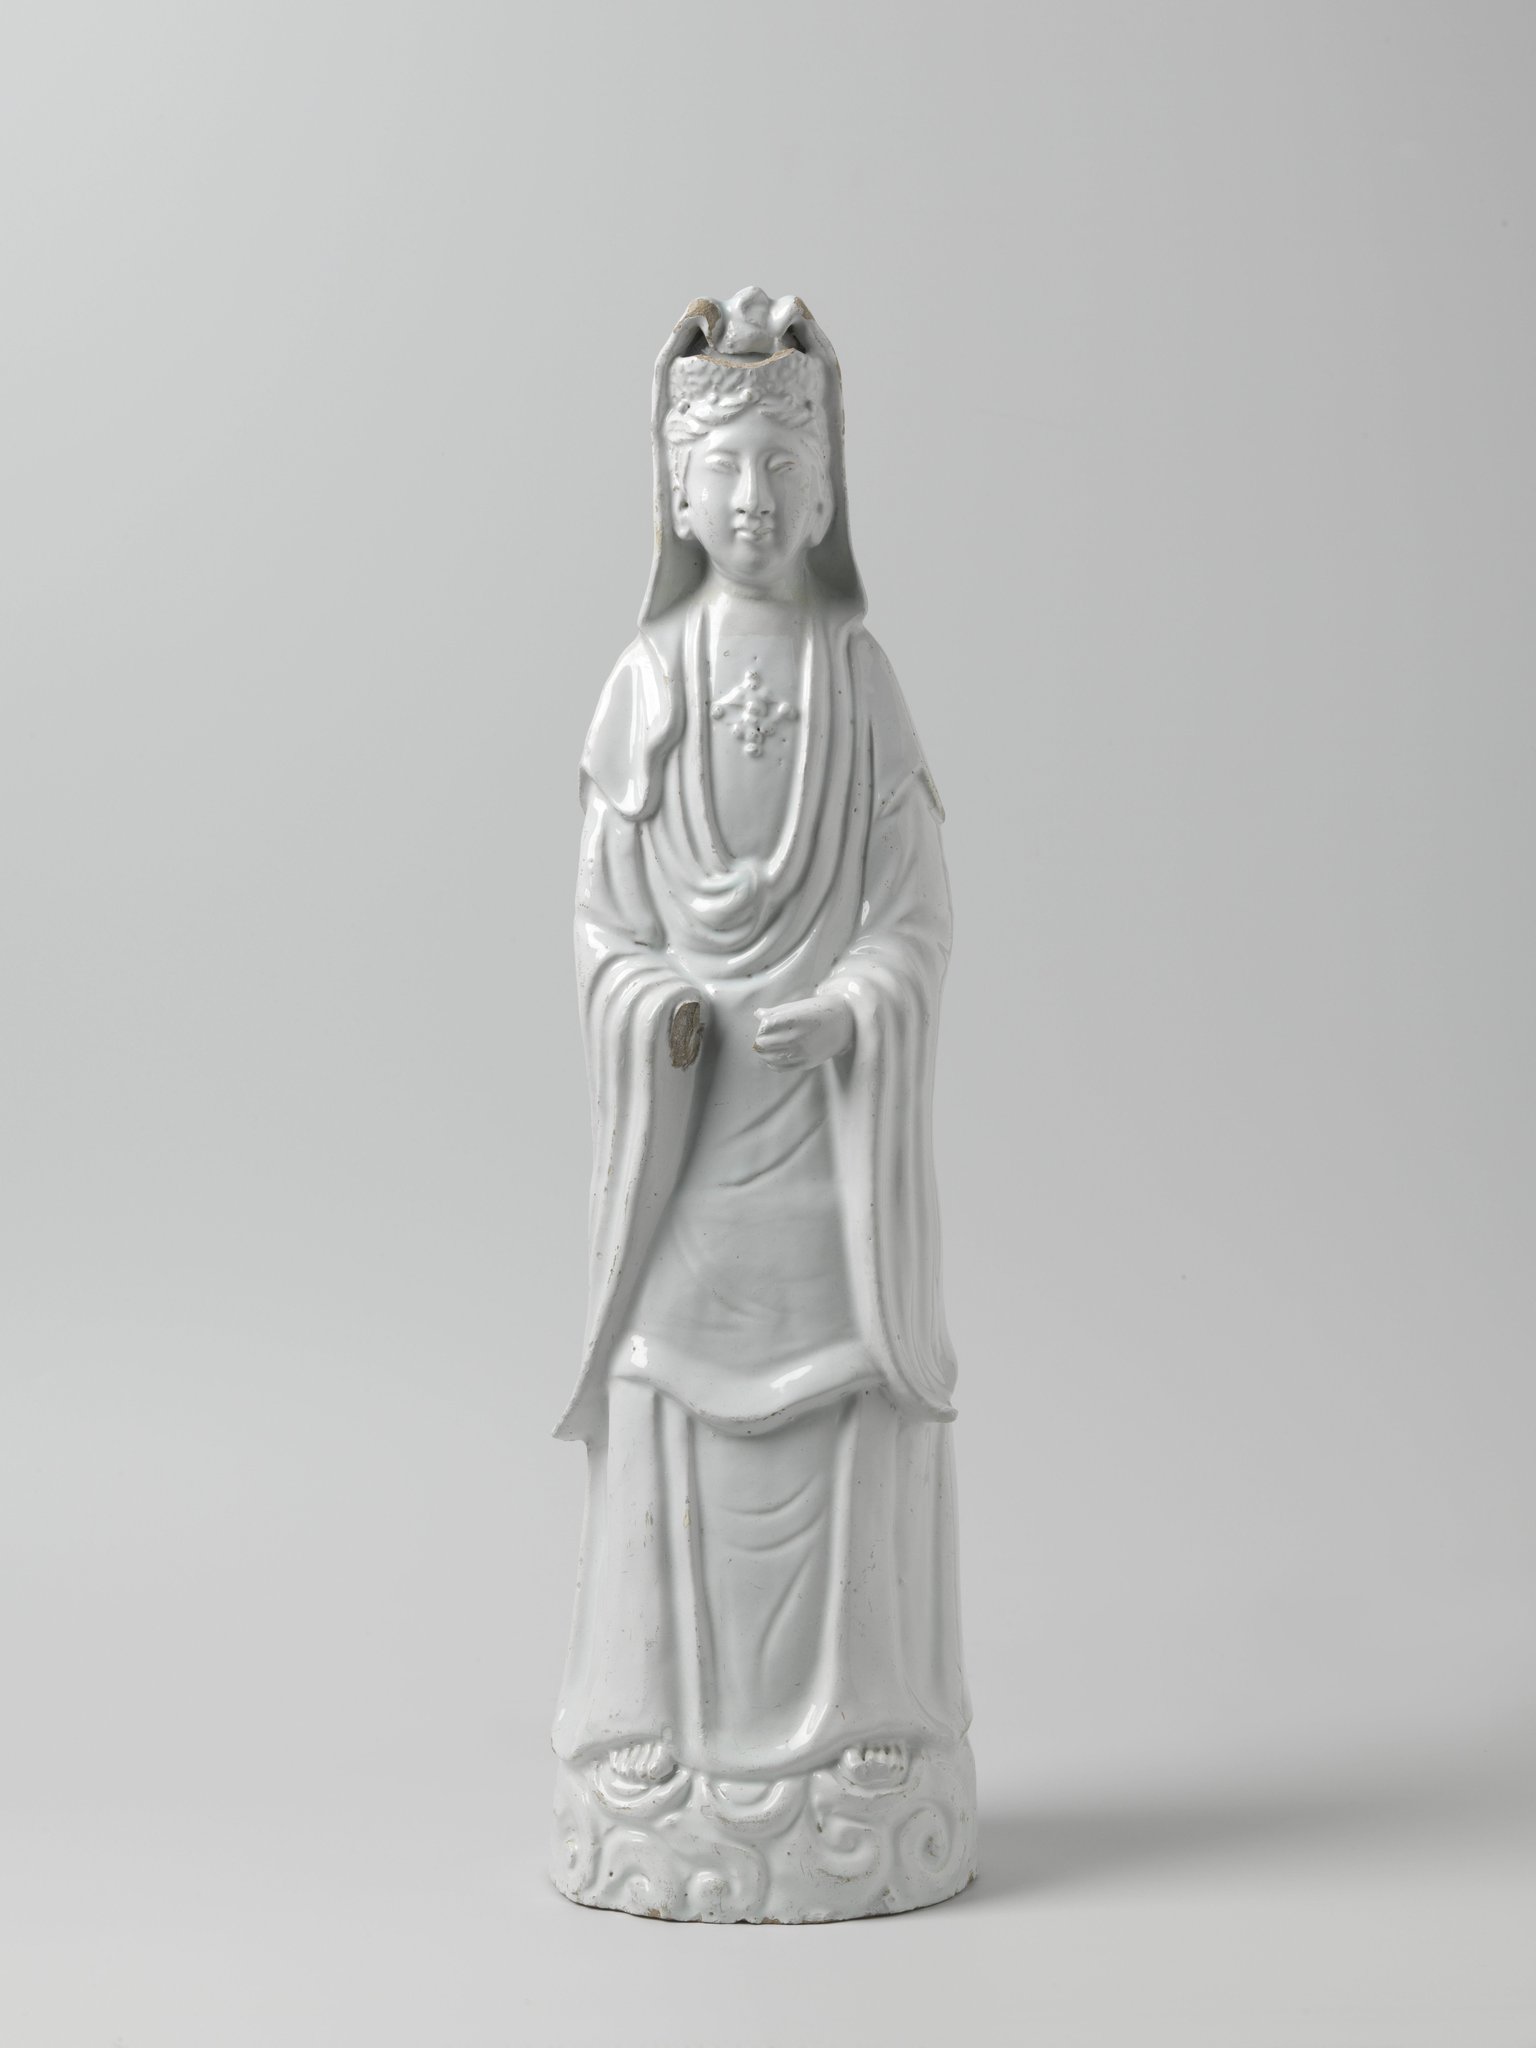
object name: vrouwenfiguur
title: Guanyin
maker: Anonymous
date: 1720-1750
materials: faience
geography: ansbach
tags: guan yin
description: Through the VOC's worldwide trading activities blanc de Chine found its way to Europe. Factories in Delft and in the German city of Meissen imitated the white porcelain, as demonstrated by this figurine. The European imitator may have used as his model the Guanyin by the famous Chinese potter He Chaozong.